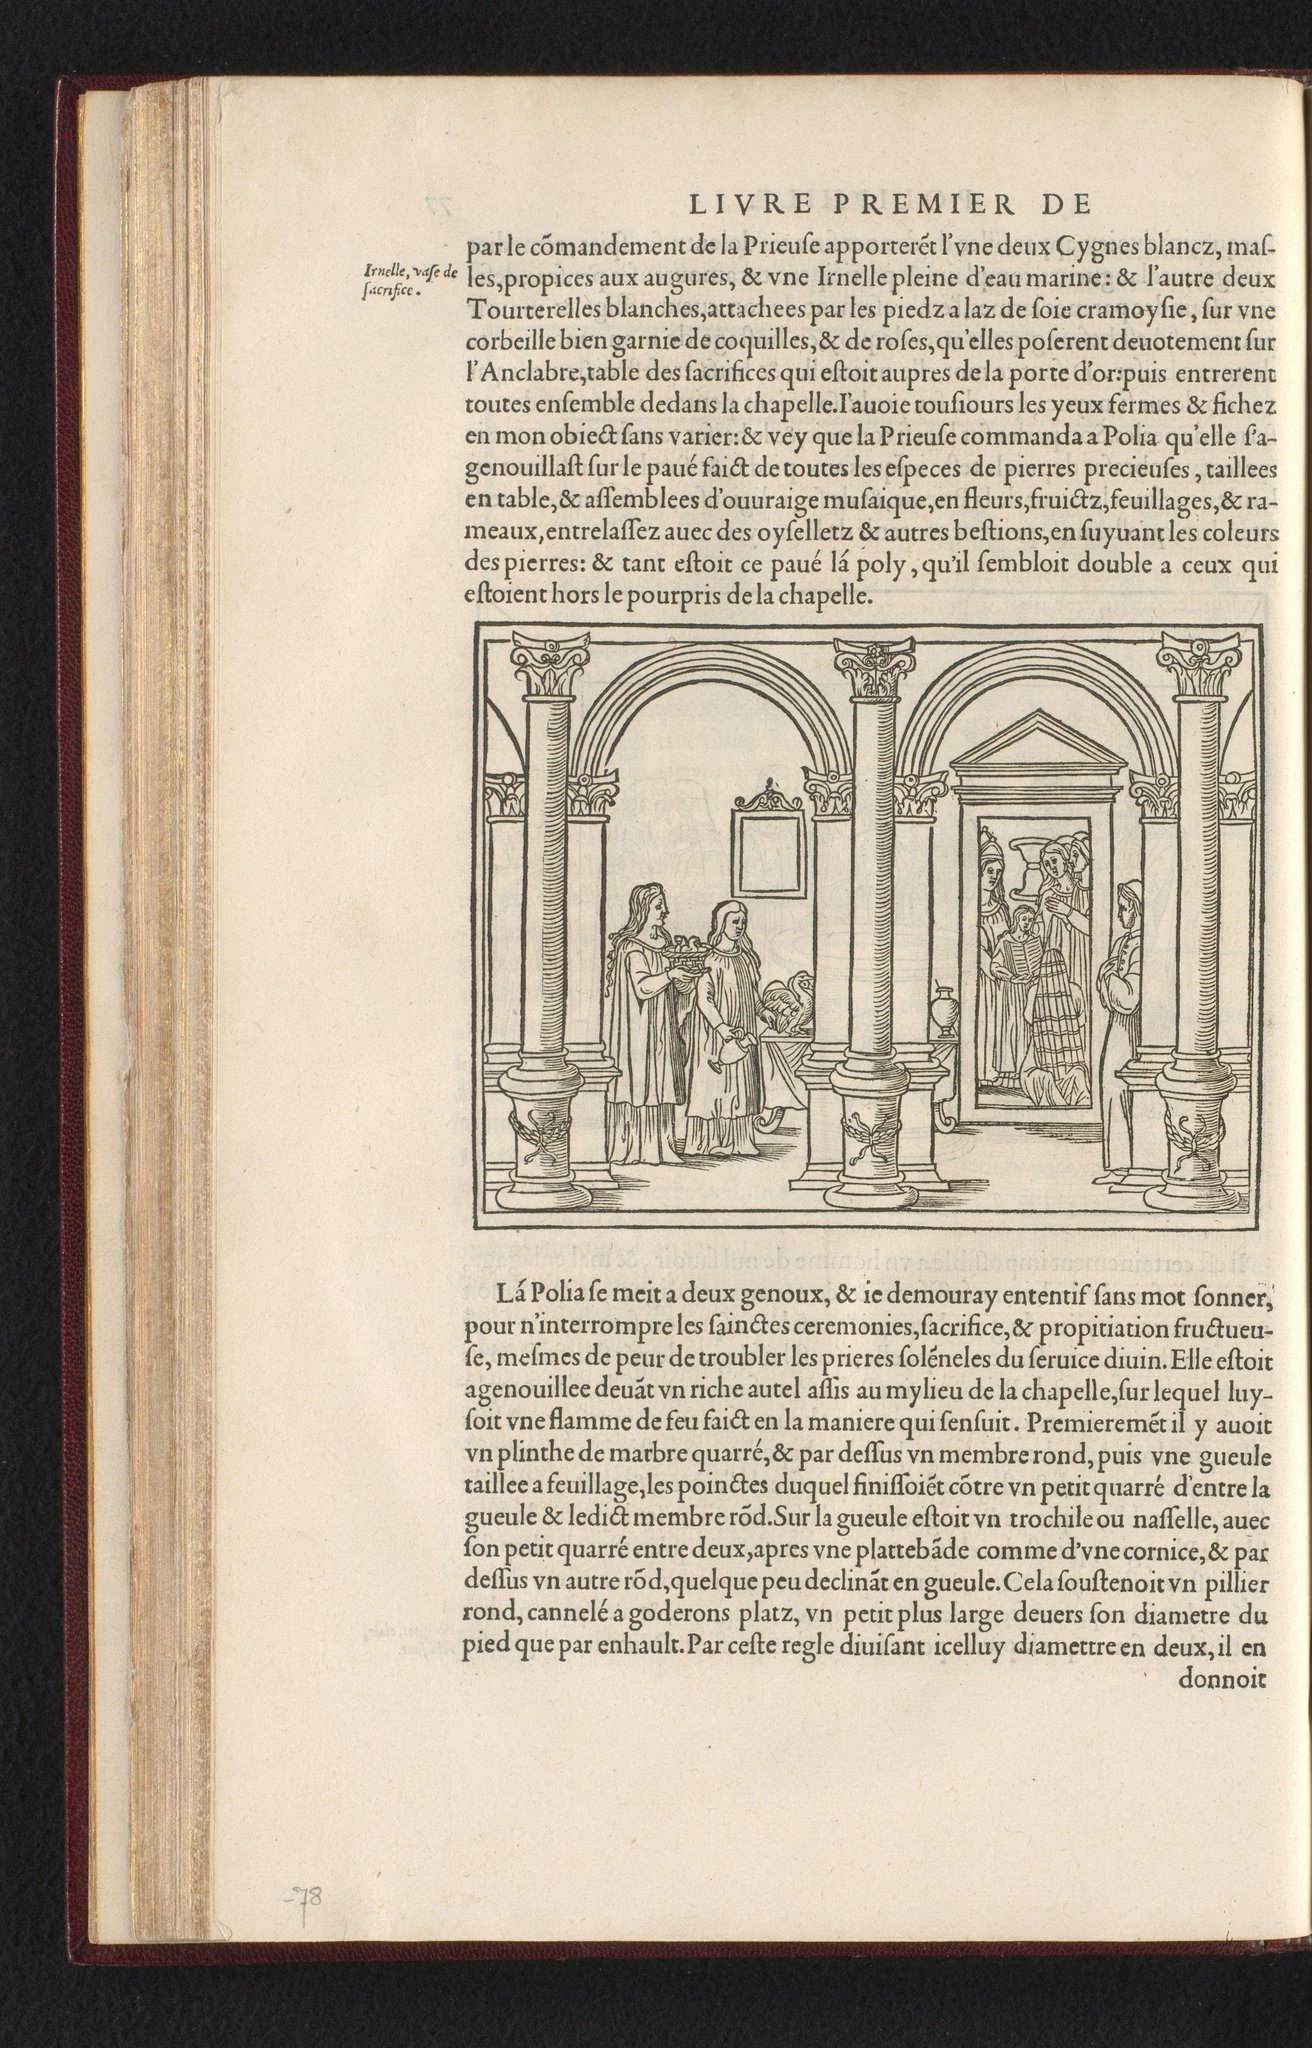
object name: book illustration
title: Poliphilo wacht op Polia geknield in een zijkamer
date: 1546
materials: paper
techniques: letterpress printing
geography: paris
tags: chapel (interior of the house), (scenes from) specific works of literature: colonna, hypnerotomachia poliphili, prayer ~ non-christian religions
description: Prent uit: Colonna, Francesco. Hypnerotomachie ou discours du songe de Poliphile, deduisant comme amour le combat a l'occasion de Polia. Parijs: Jacques Kerver, 1546, verso fol. 77.